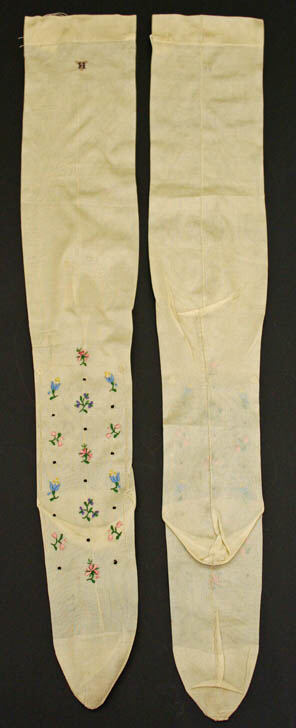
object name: stocking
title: Stockings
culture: french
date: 1801-1900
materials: silk